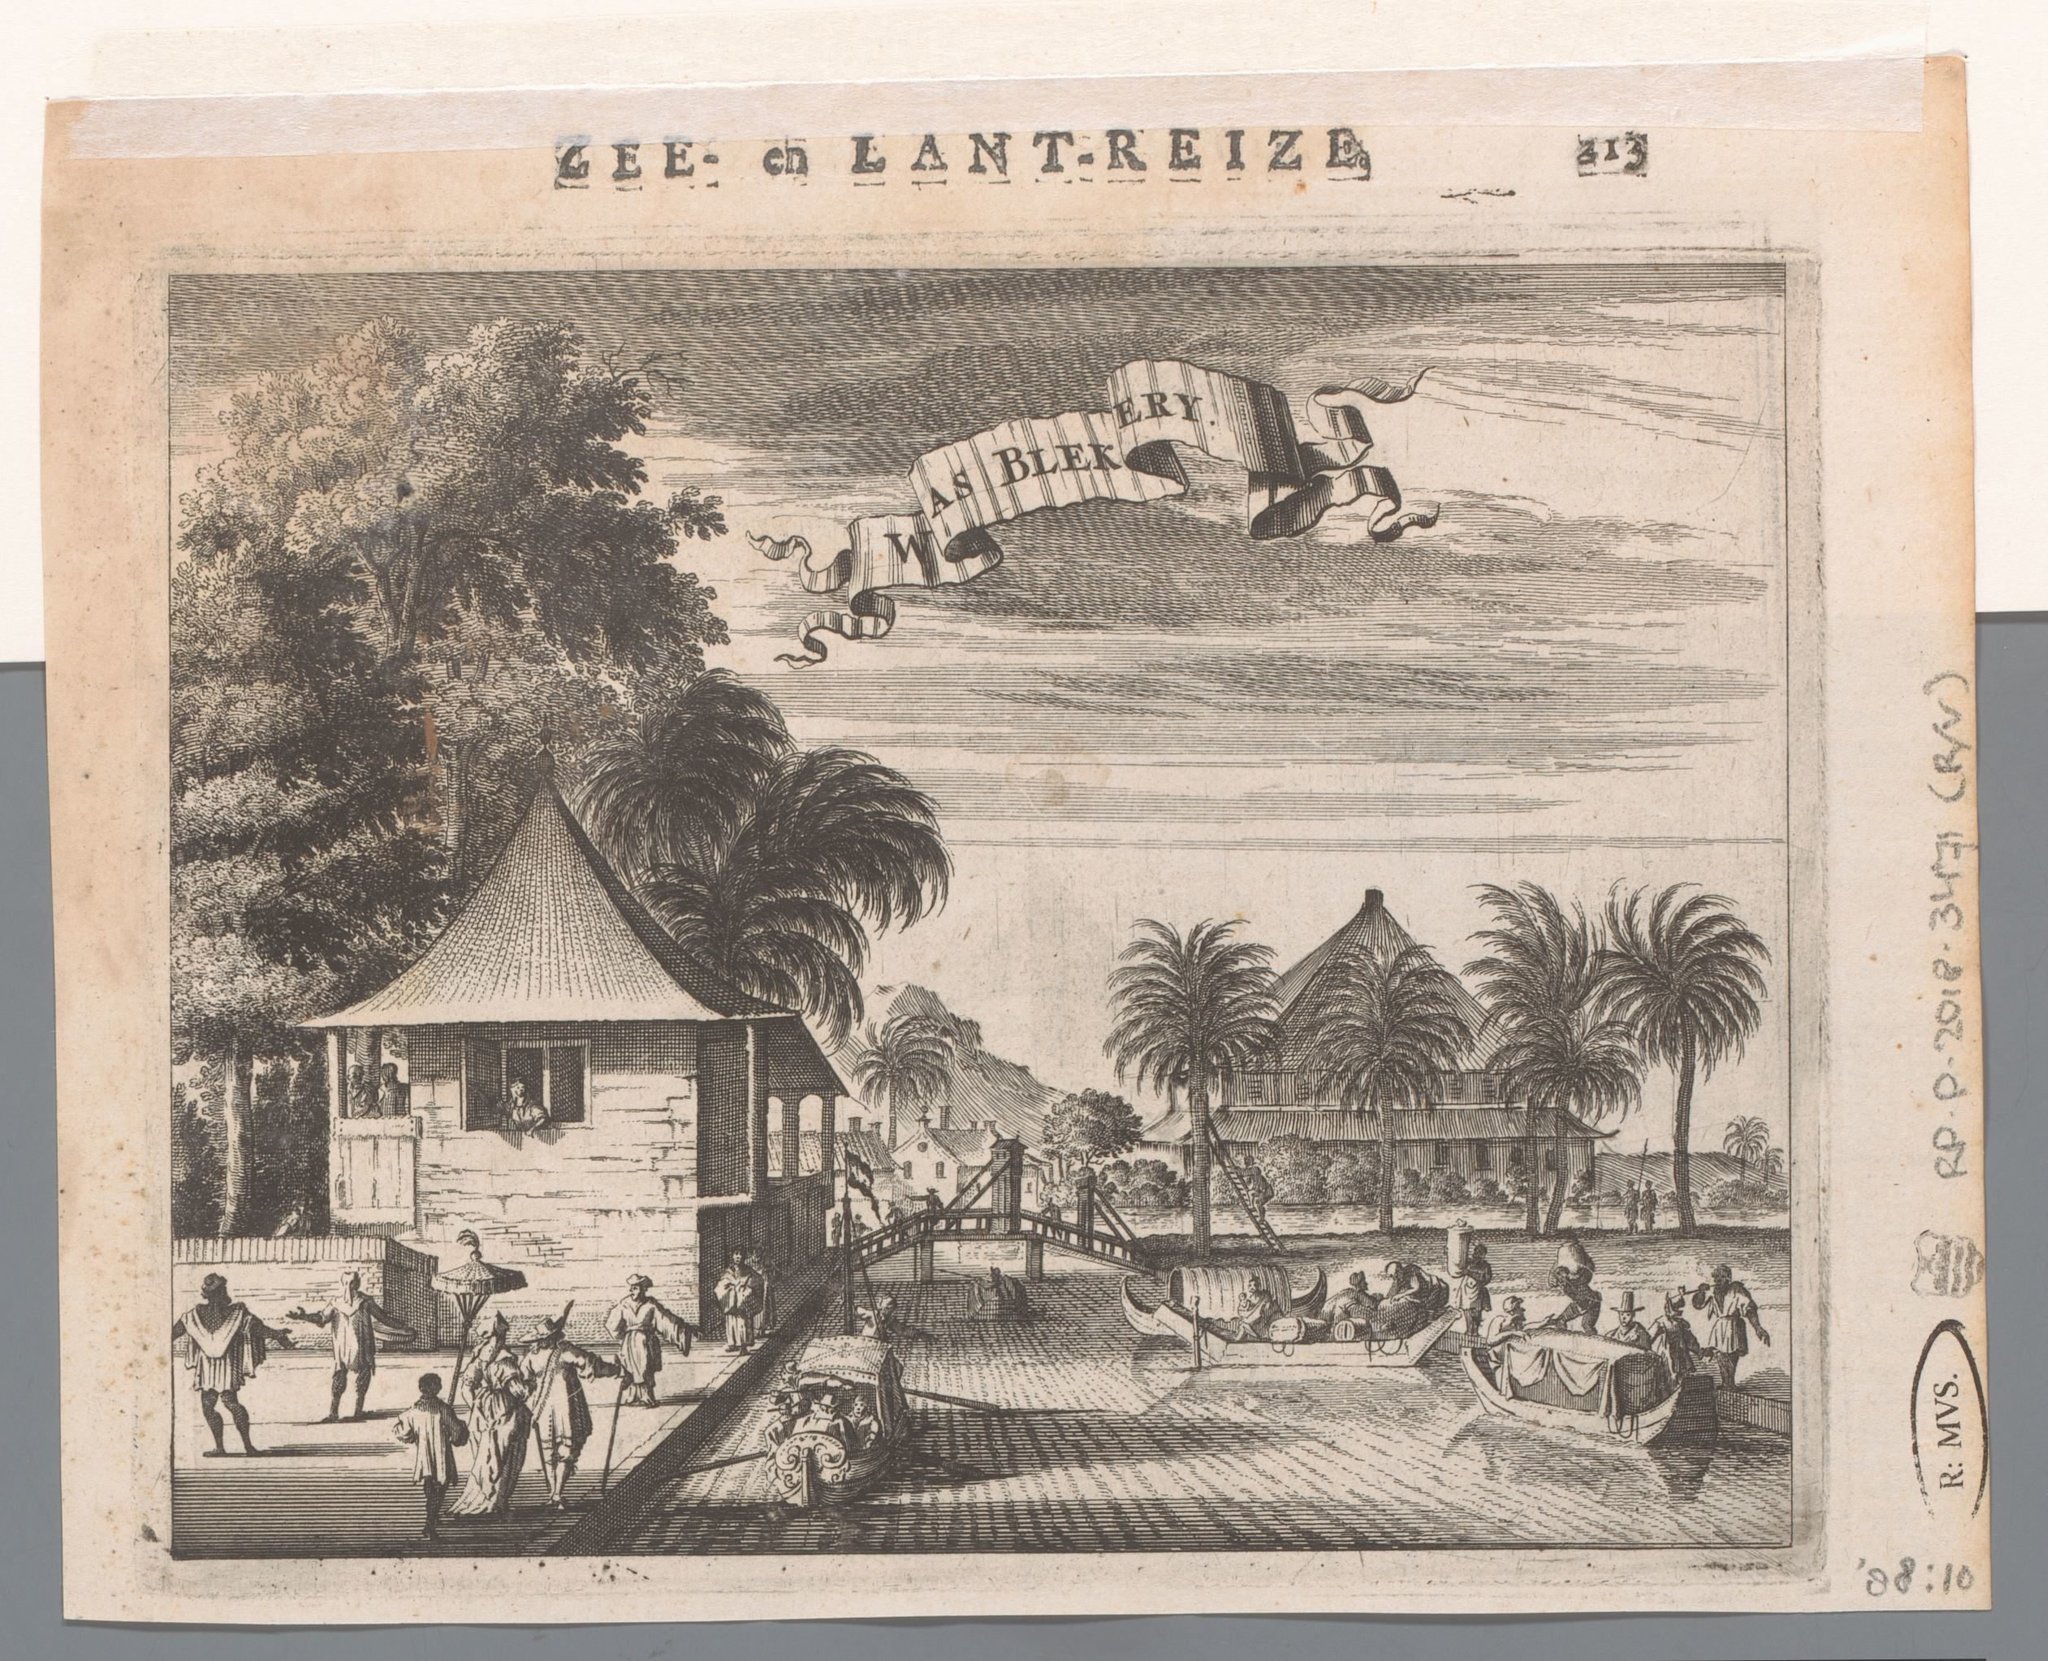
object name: print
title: Was blekery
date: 1682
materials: paper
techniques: engraving, etching, letterpress printing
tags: bee-hive, batavia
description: Prent uit: Nieuhof, Joan. Joan Nieuhofs zee en lant-reize, door verscheide Gewesten van Oostindien (...). Amsterdam: Jacob van Meurs, 1682, p. 213.